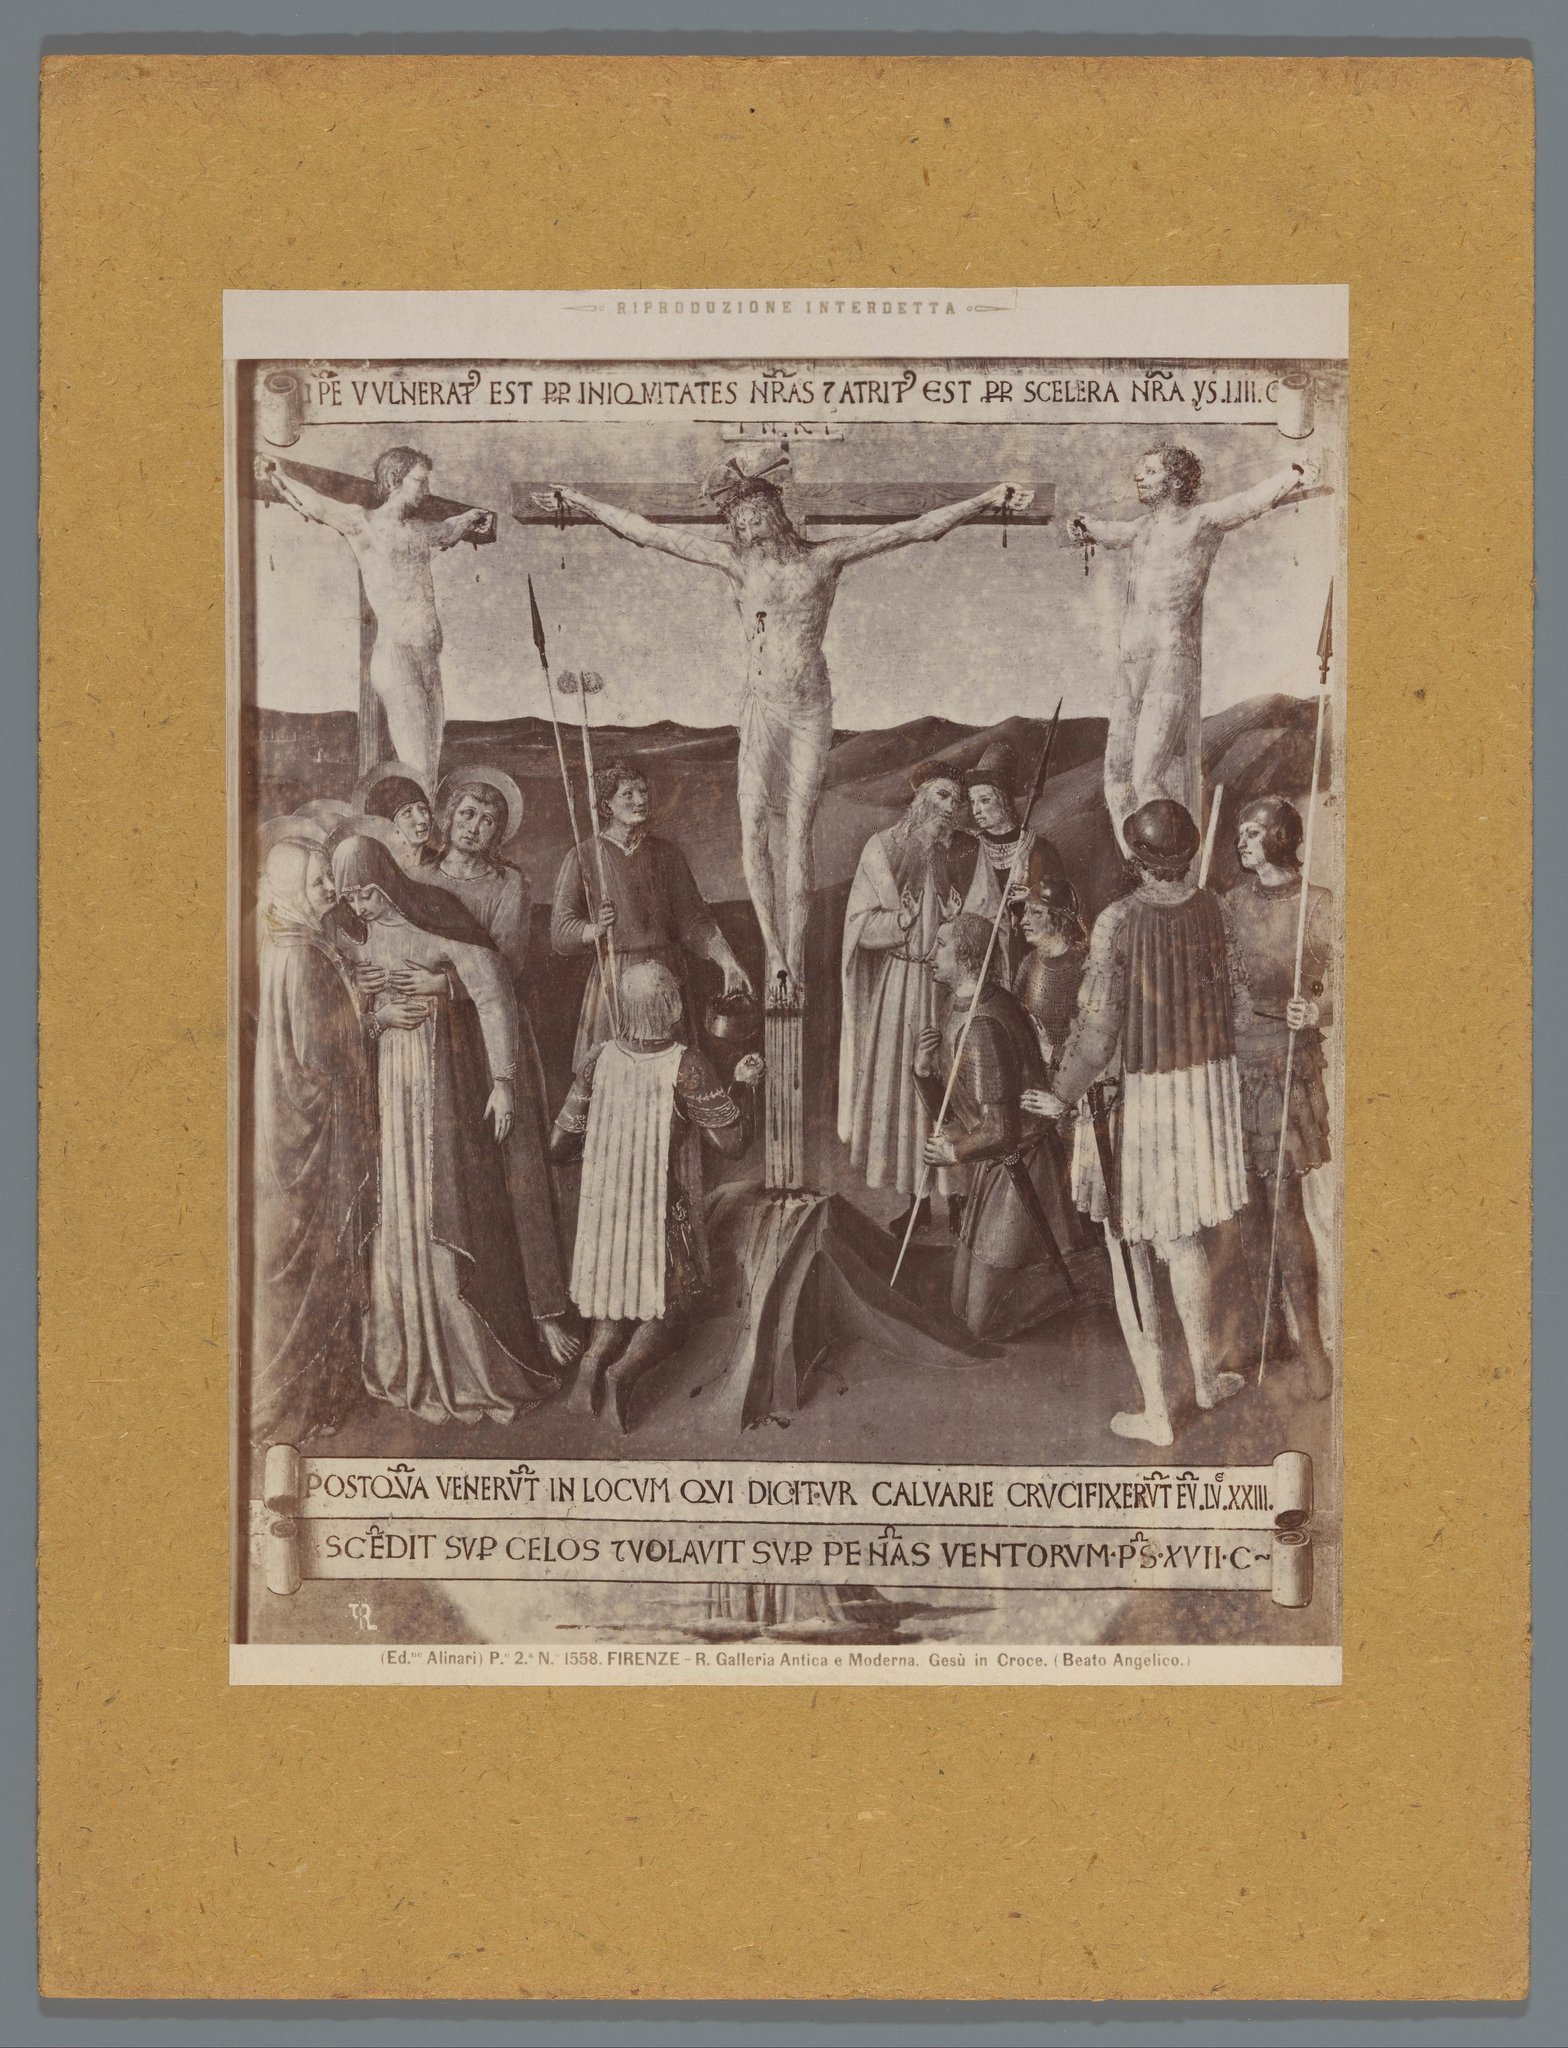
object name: photograph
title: Fotoreproductie van een schilderij door Fra Angelico, voorstellende de kruisiging van Christus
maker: fra angelico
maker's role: painter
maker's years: 1400-1455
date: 1875-1900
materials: cardboard, photographic support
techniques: albumen print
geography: italy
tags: christ on the cross combined with other scenes from the passion - dd - the three crosses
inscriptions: inscription:, number: ‘P.e 2.a N.o 1558.’, collector's mark: Lugt 3937